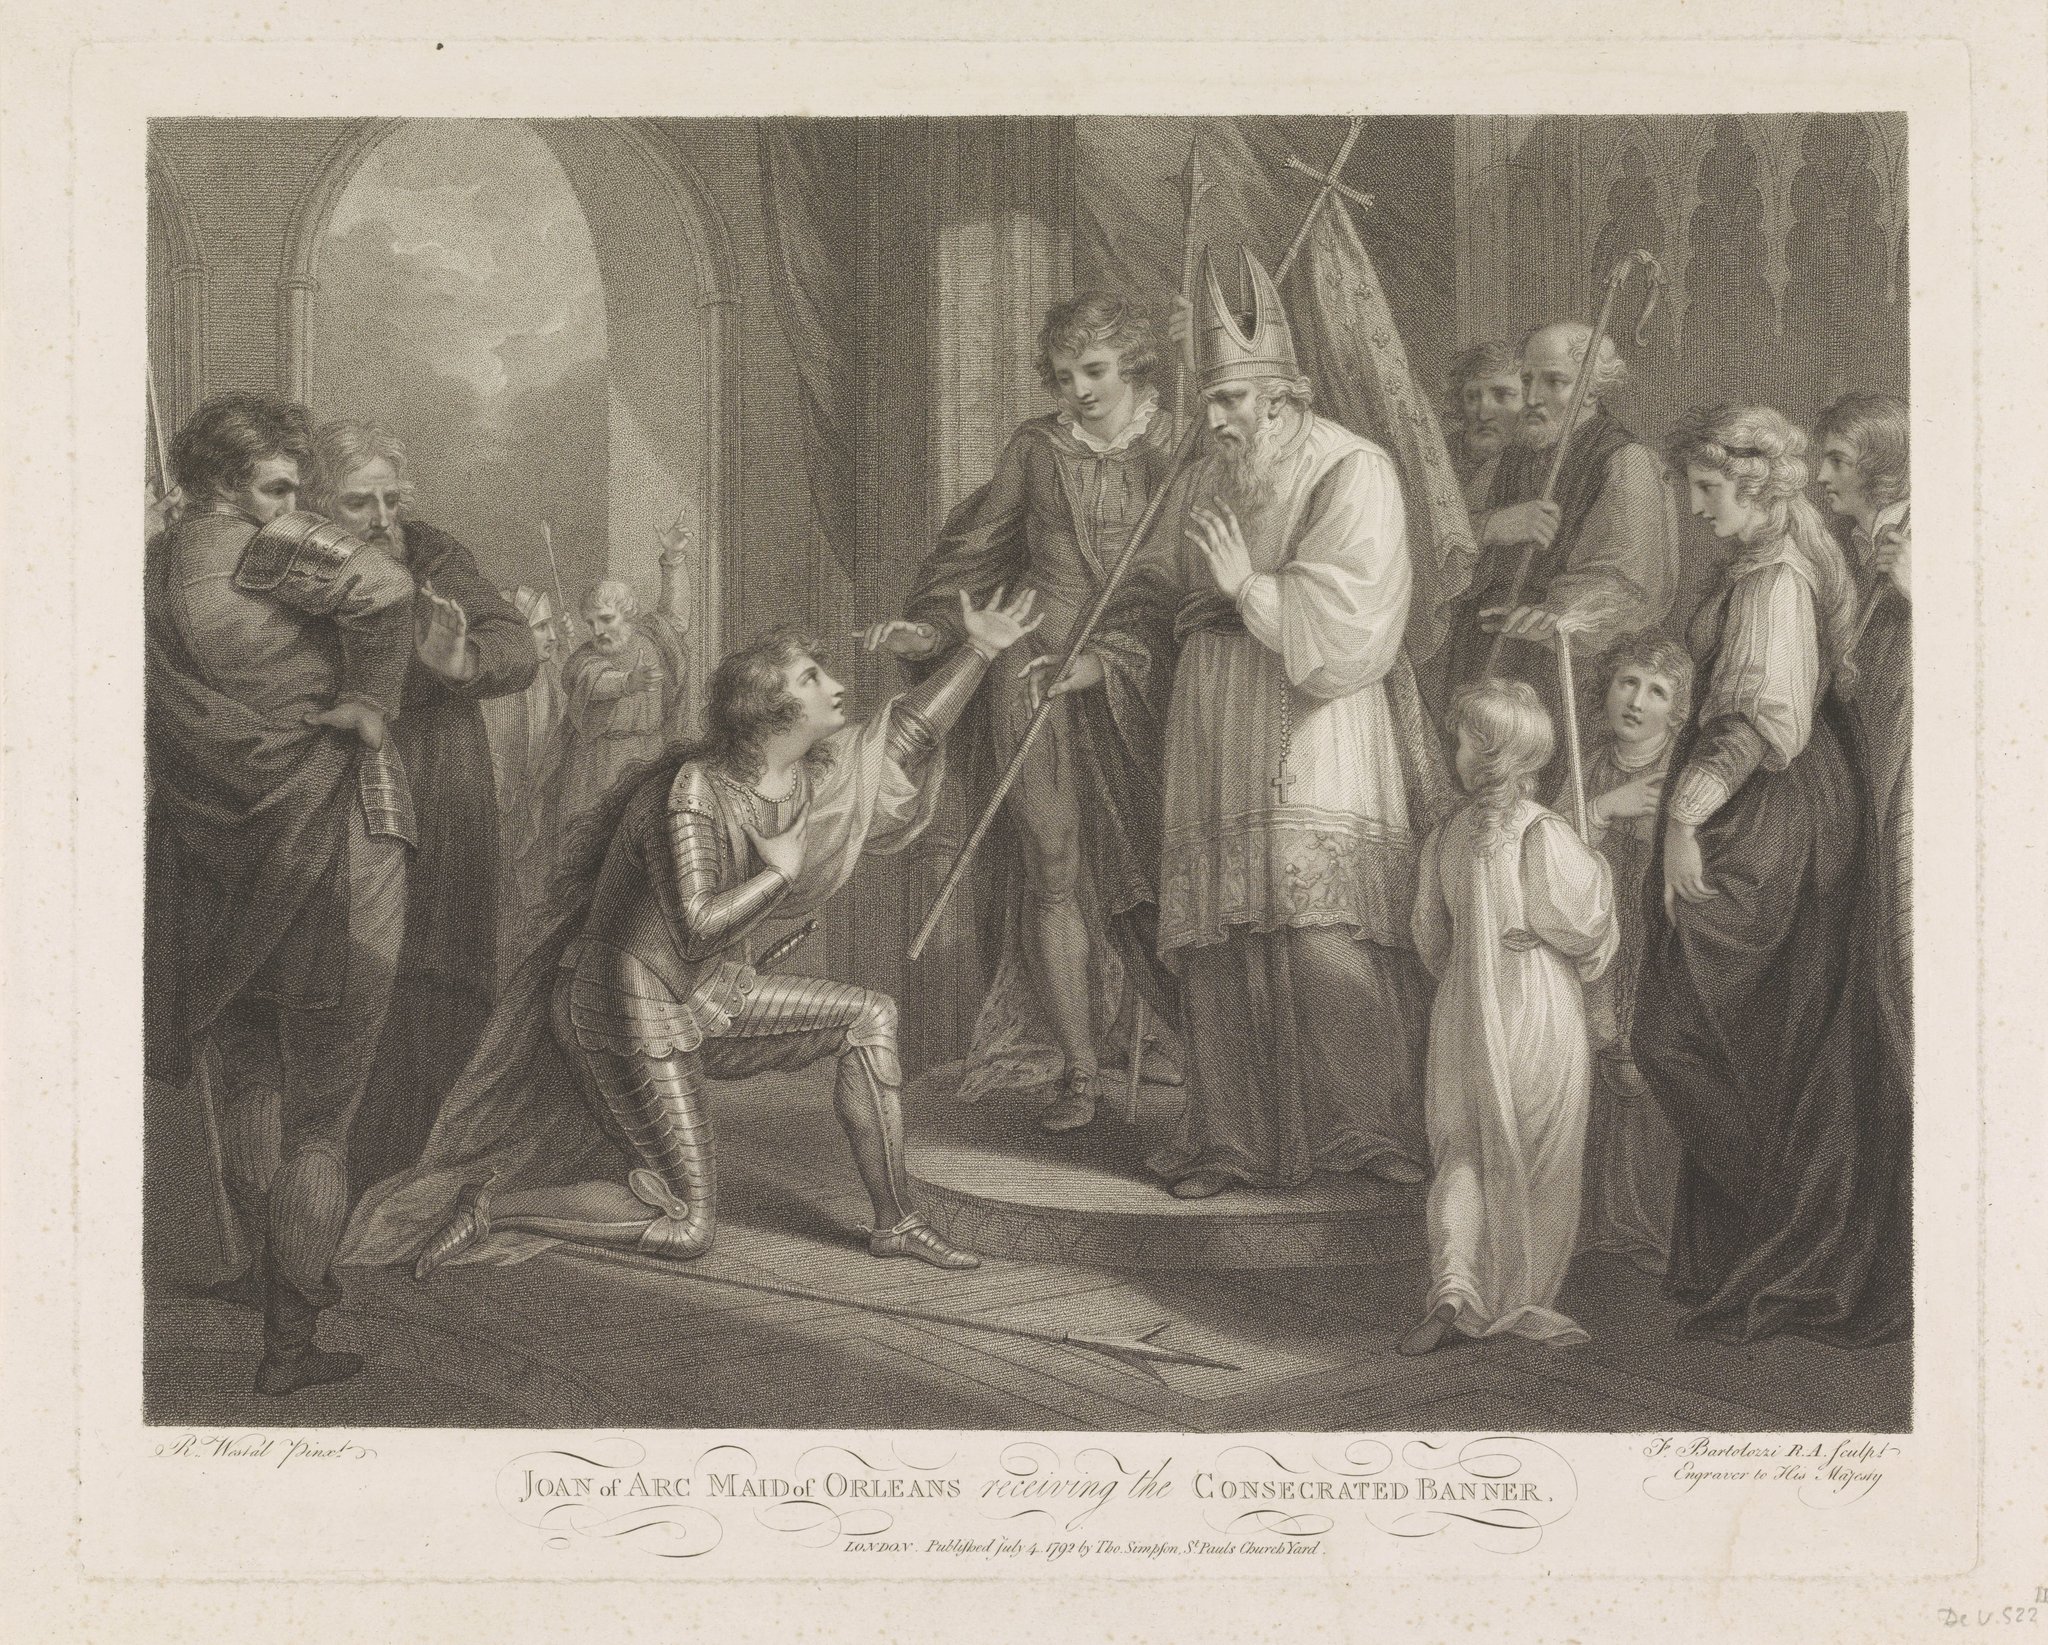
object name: print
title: Jeanne d'Arc ontvangt de gewijde banier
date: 1792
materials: paper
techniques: etching, engraving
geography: london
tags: historical events and situations; historical persons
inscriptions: collector's mark: Lugt 2165, collector's mark: Lugt 12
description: Jeanne d'Arc zit geknield voor een bisschop en ontvangt de gewijde banier in een kerk. Omstanders kijken toe. Titel in het Engels in de onderamarge.